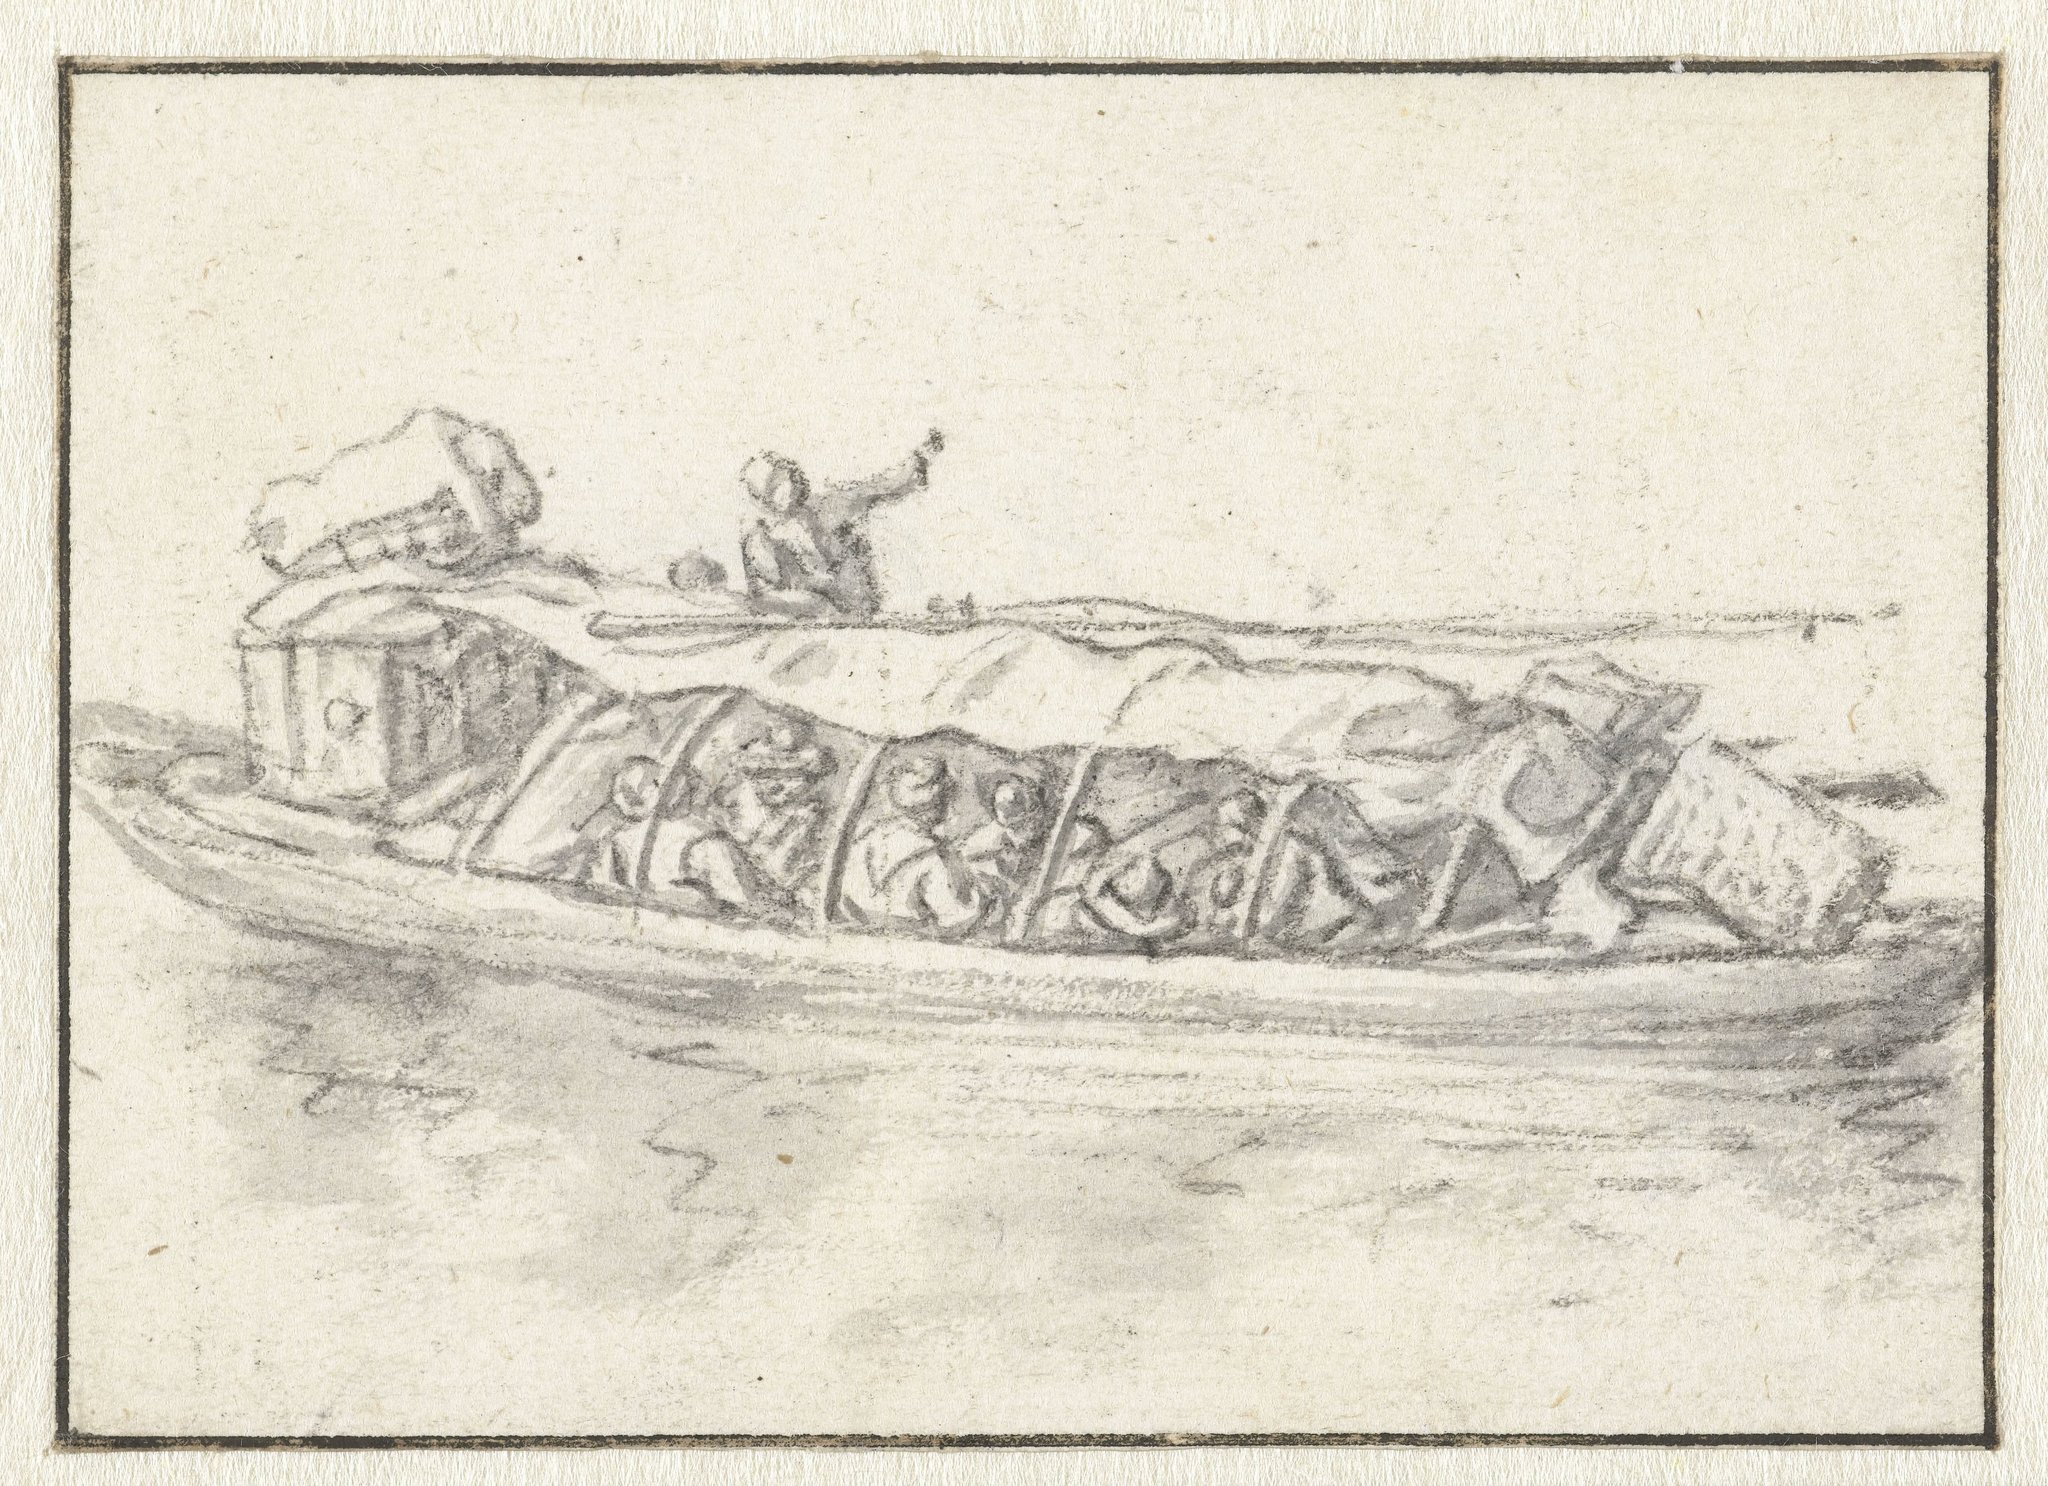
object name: drawing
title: Overdekte schuit met veel personen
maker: herman saftleven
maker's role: draughtsman, painter, print maker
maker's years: 1609-1685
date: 1619-1685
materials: chalk, paper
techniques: brush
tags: passengers ~ ship, oaring, sculling